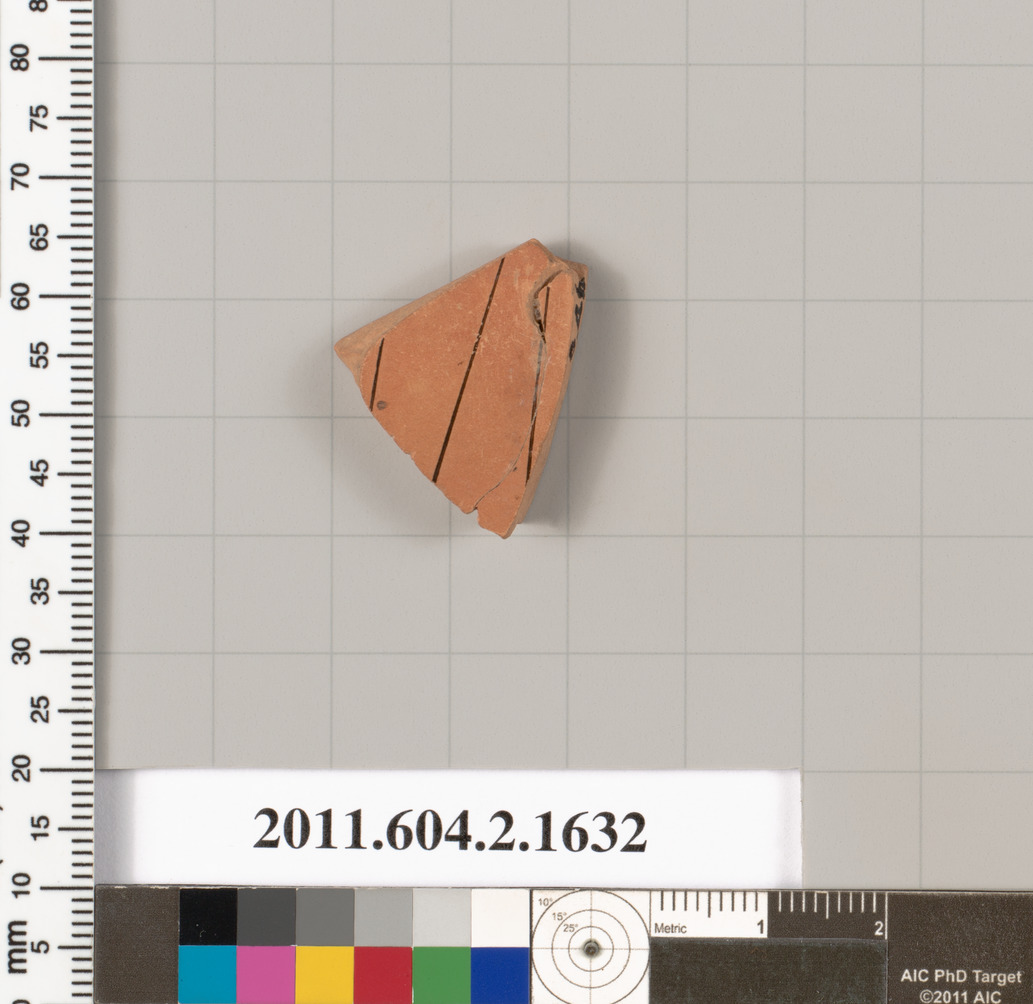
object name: skyphos fragment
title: Terracotta fragment of a skyphos (deep drinking cup)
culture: greek, attic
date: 460-440 BCE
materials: terracotta